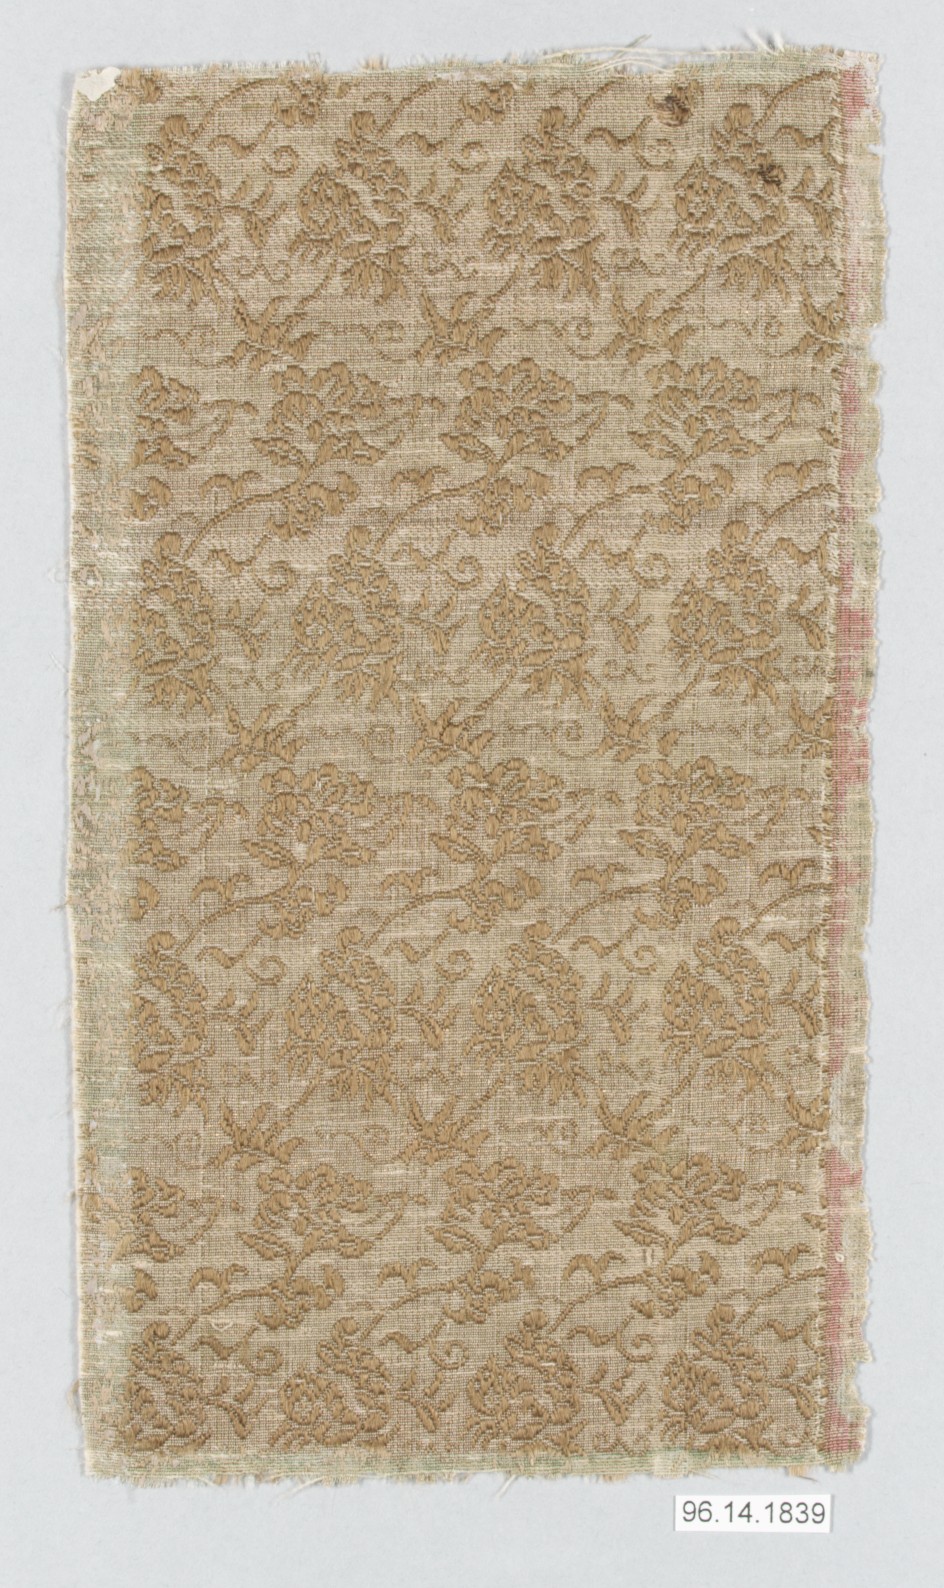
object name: piece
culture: japanese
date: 1701-1800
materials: metal thread, silk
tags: leaves